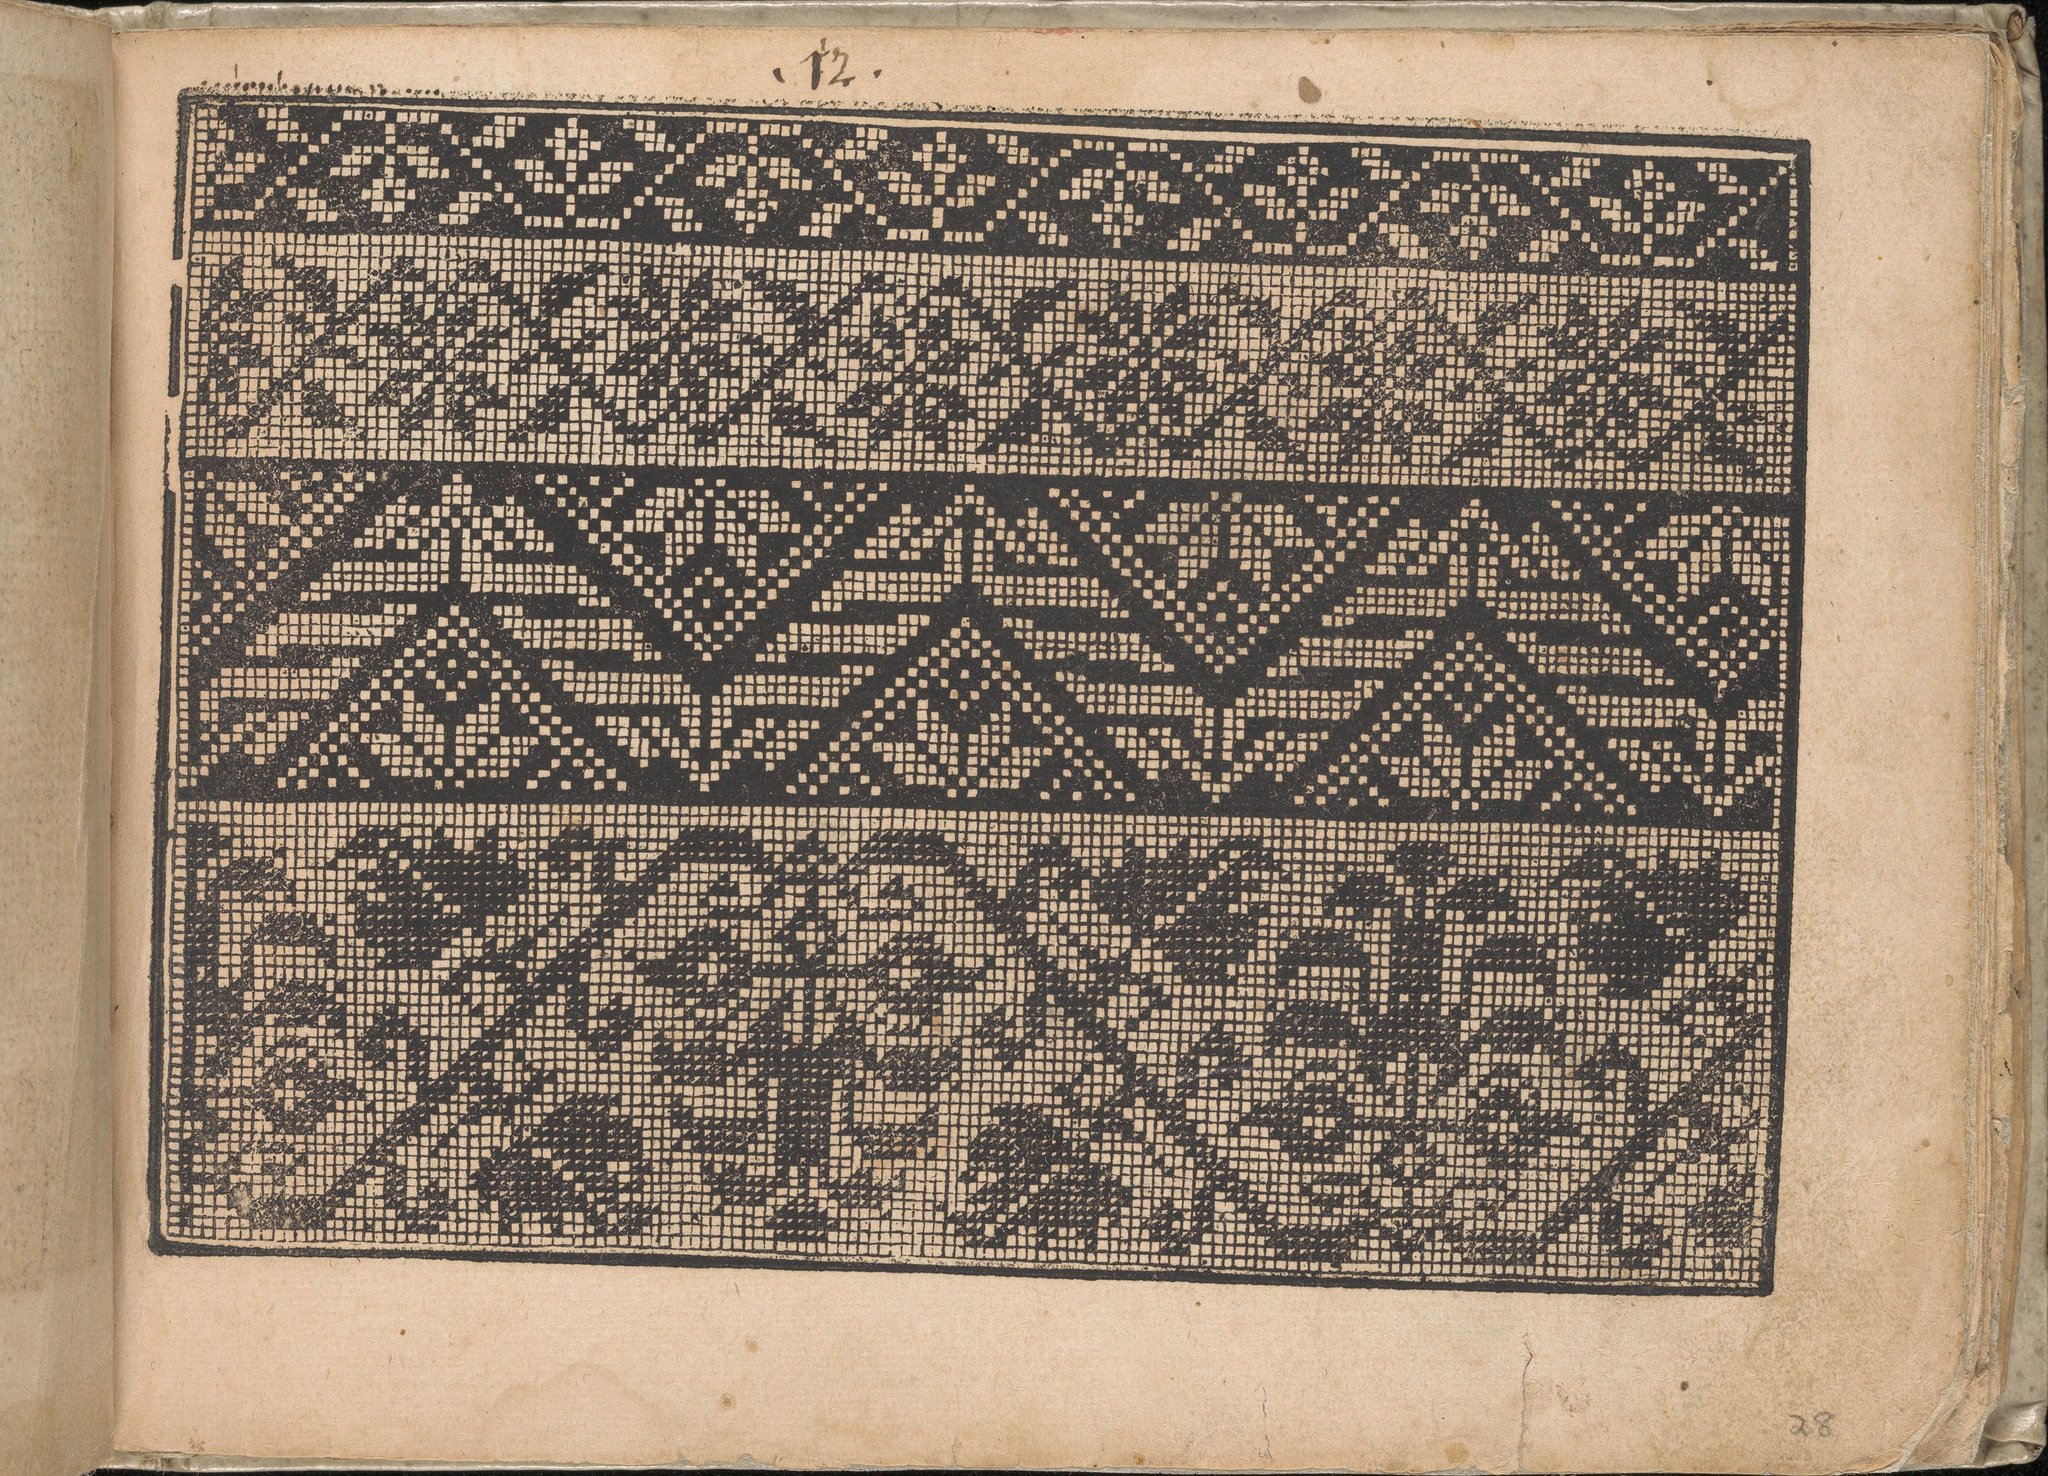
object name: book print ornament architecture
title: Neu künstlich Modelbuch (page 28r)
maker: bernhard jobin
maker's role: publisher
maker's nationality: swiss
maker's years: 1535-1597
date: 1598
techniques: woodcut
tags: flowers